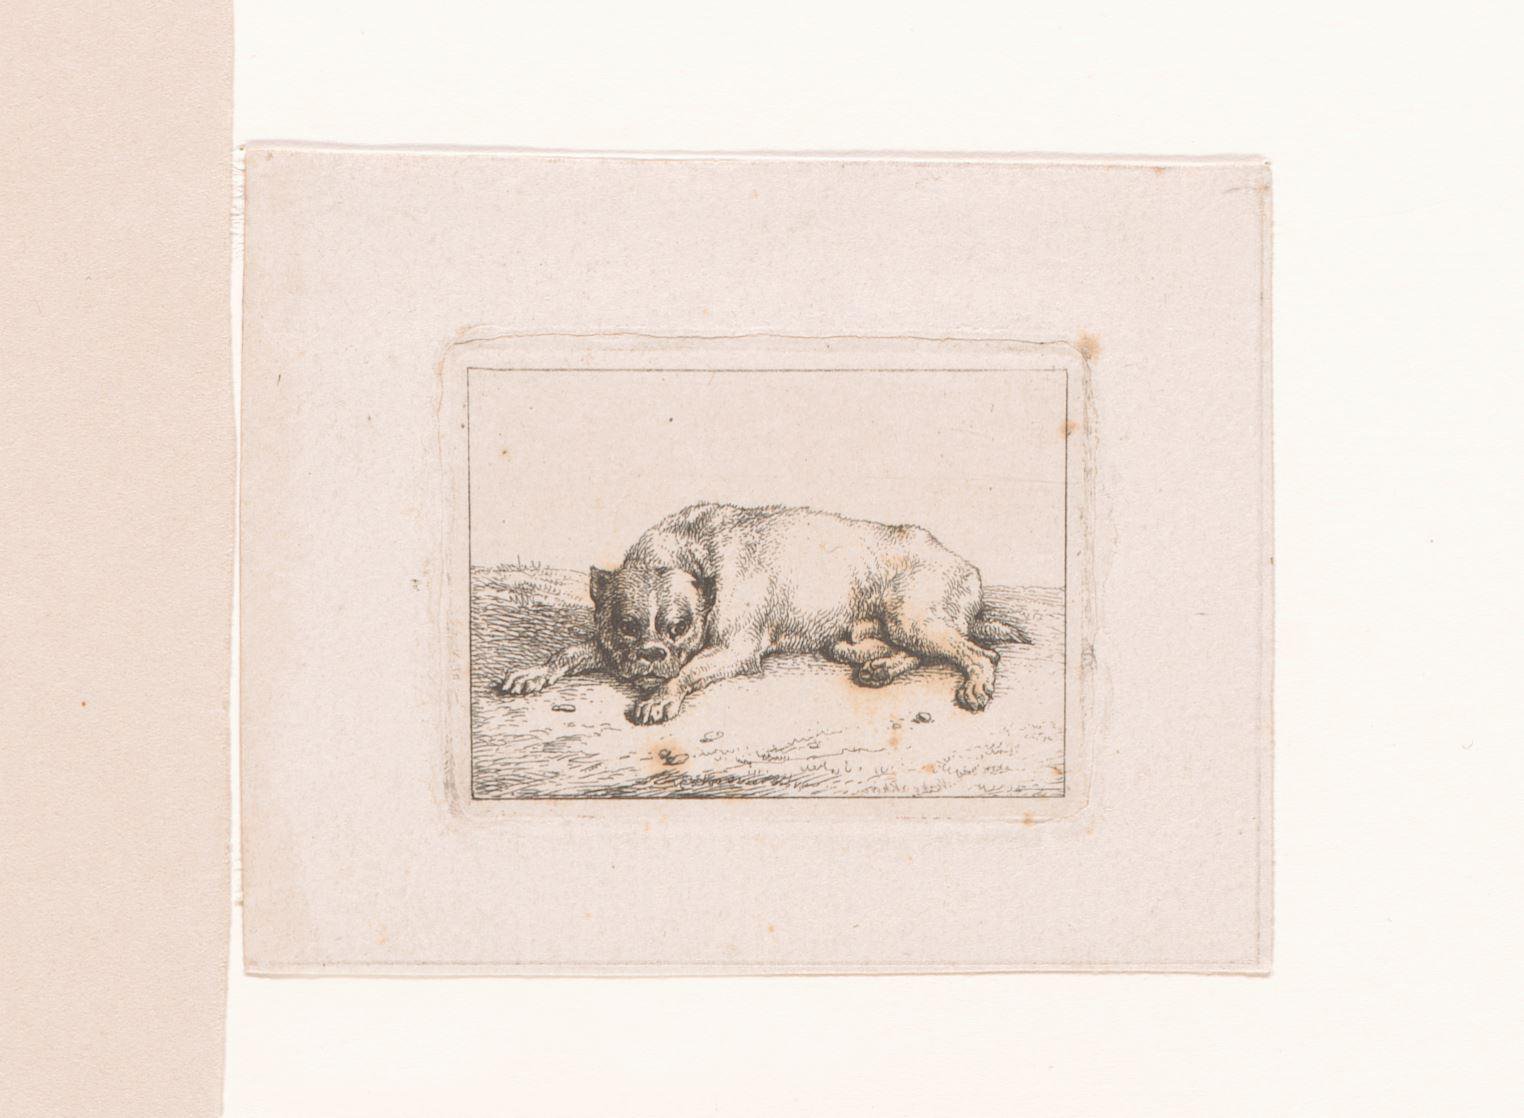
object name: print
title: Bulldog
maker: eugène verboeckhoven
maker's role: draughtsman, painter, print maker, printer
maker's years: 1798-1881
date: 1830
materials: paper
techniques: etching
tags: dog (with name of kind)